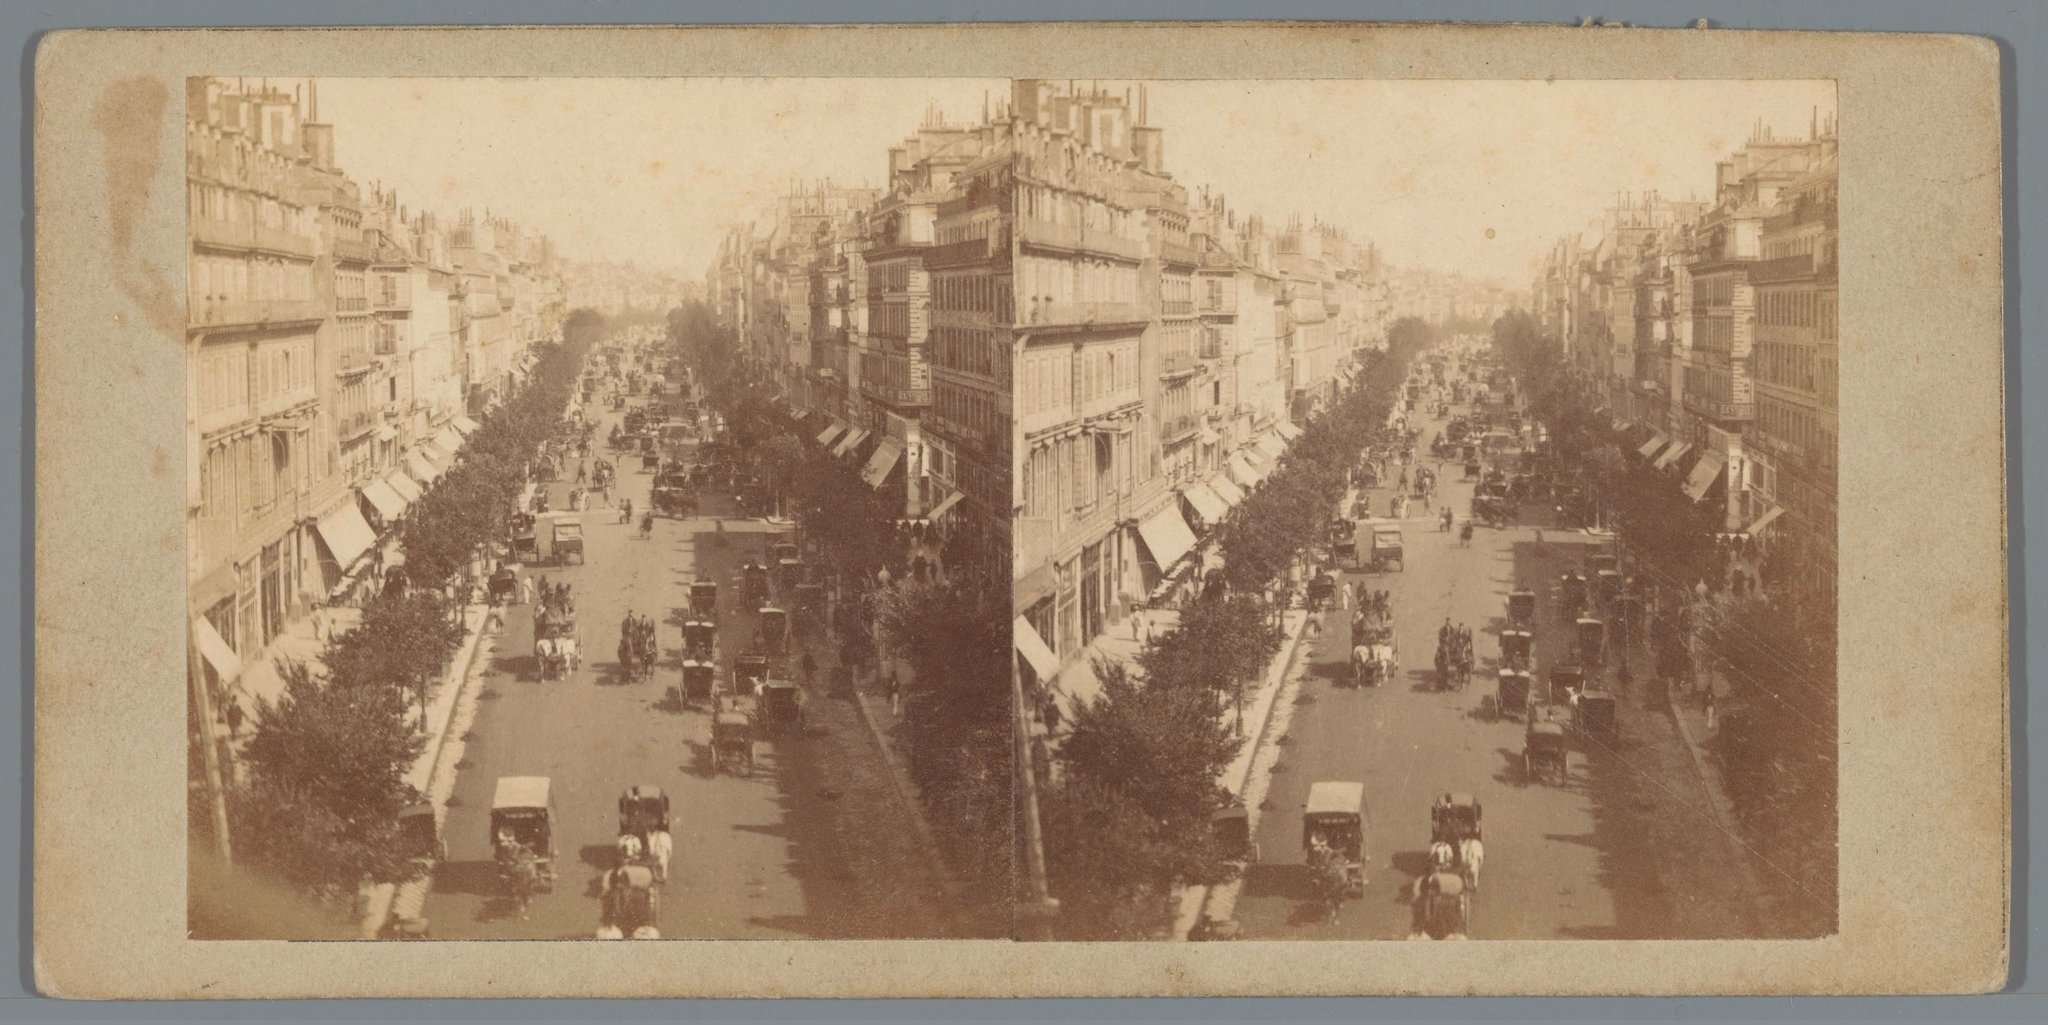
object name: stereograph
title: Gezicht op de Boulevard des Italiens in Parijs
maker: Anonymous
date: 1850-1880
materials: cardboard, photographic support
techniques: albumen print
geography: paris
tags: animal traction, animal-drawn vehicle (carriage etc.), street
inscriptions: inscription: ‘Boulevard des Italiens’